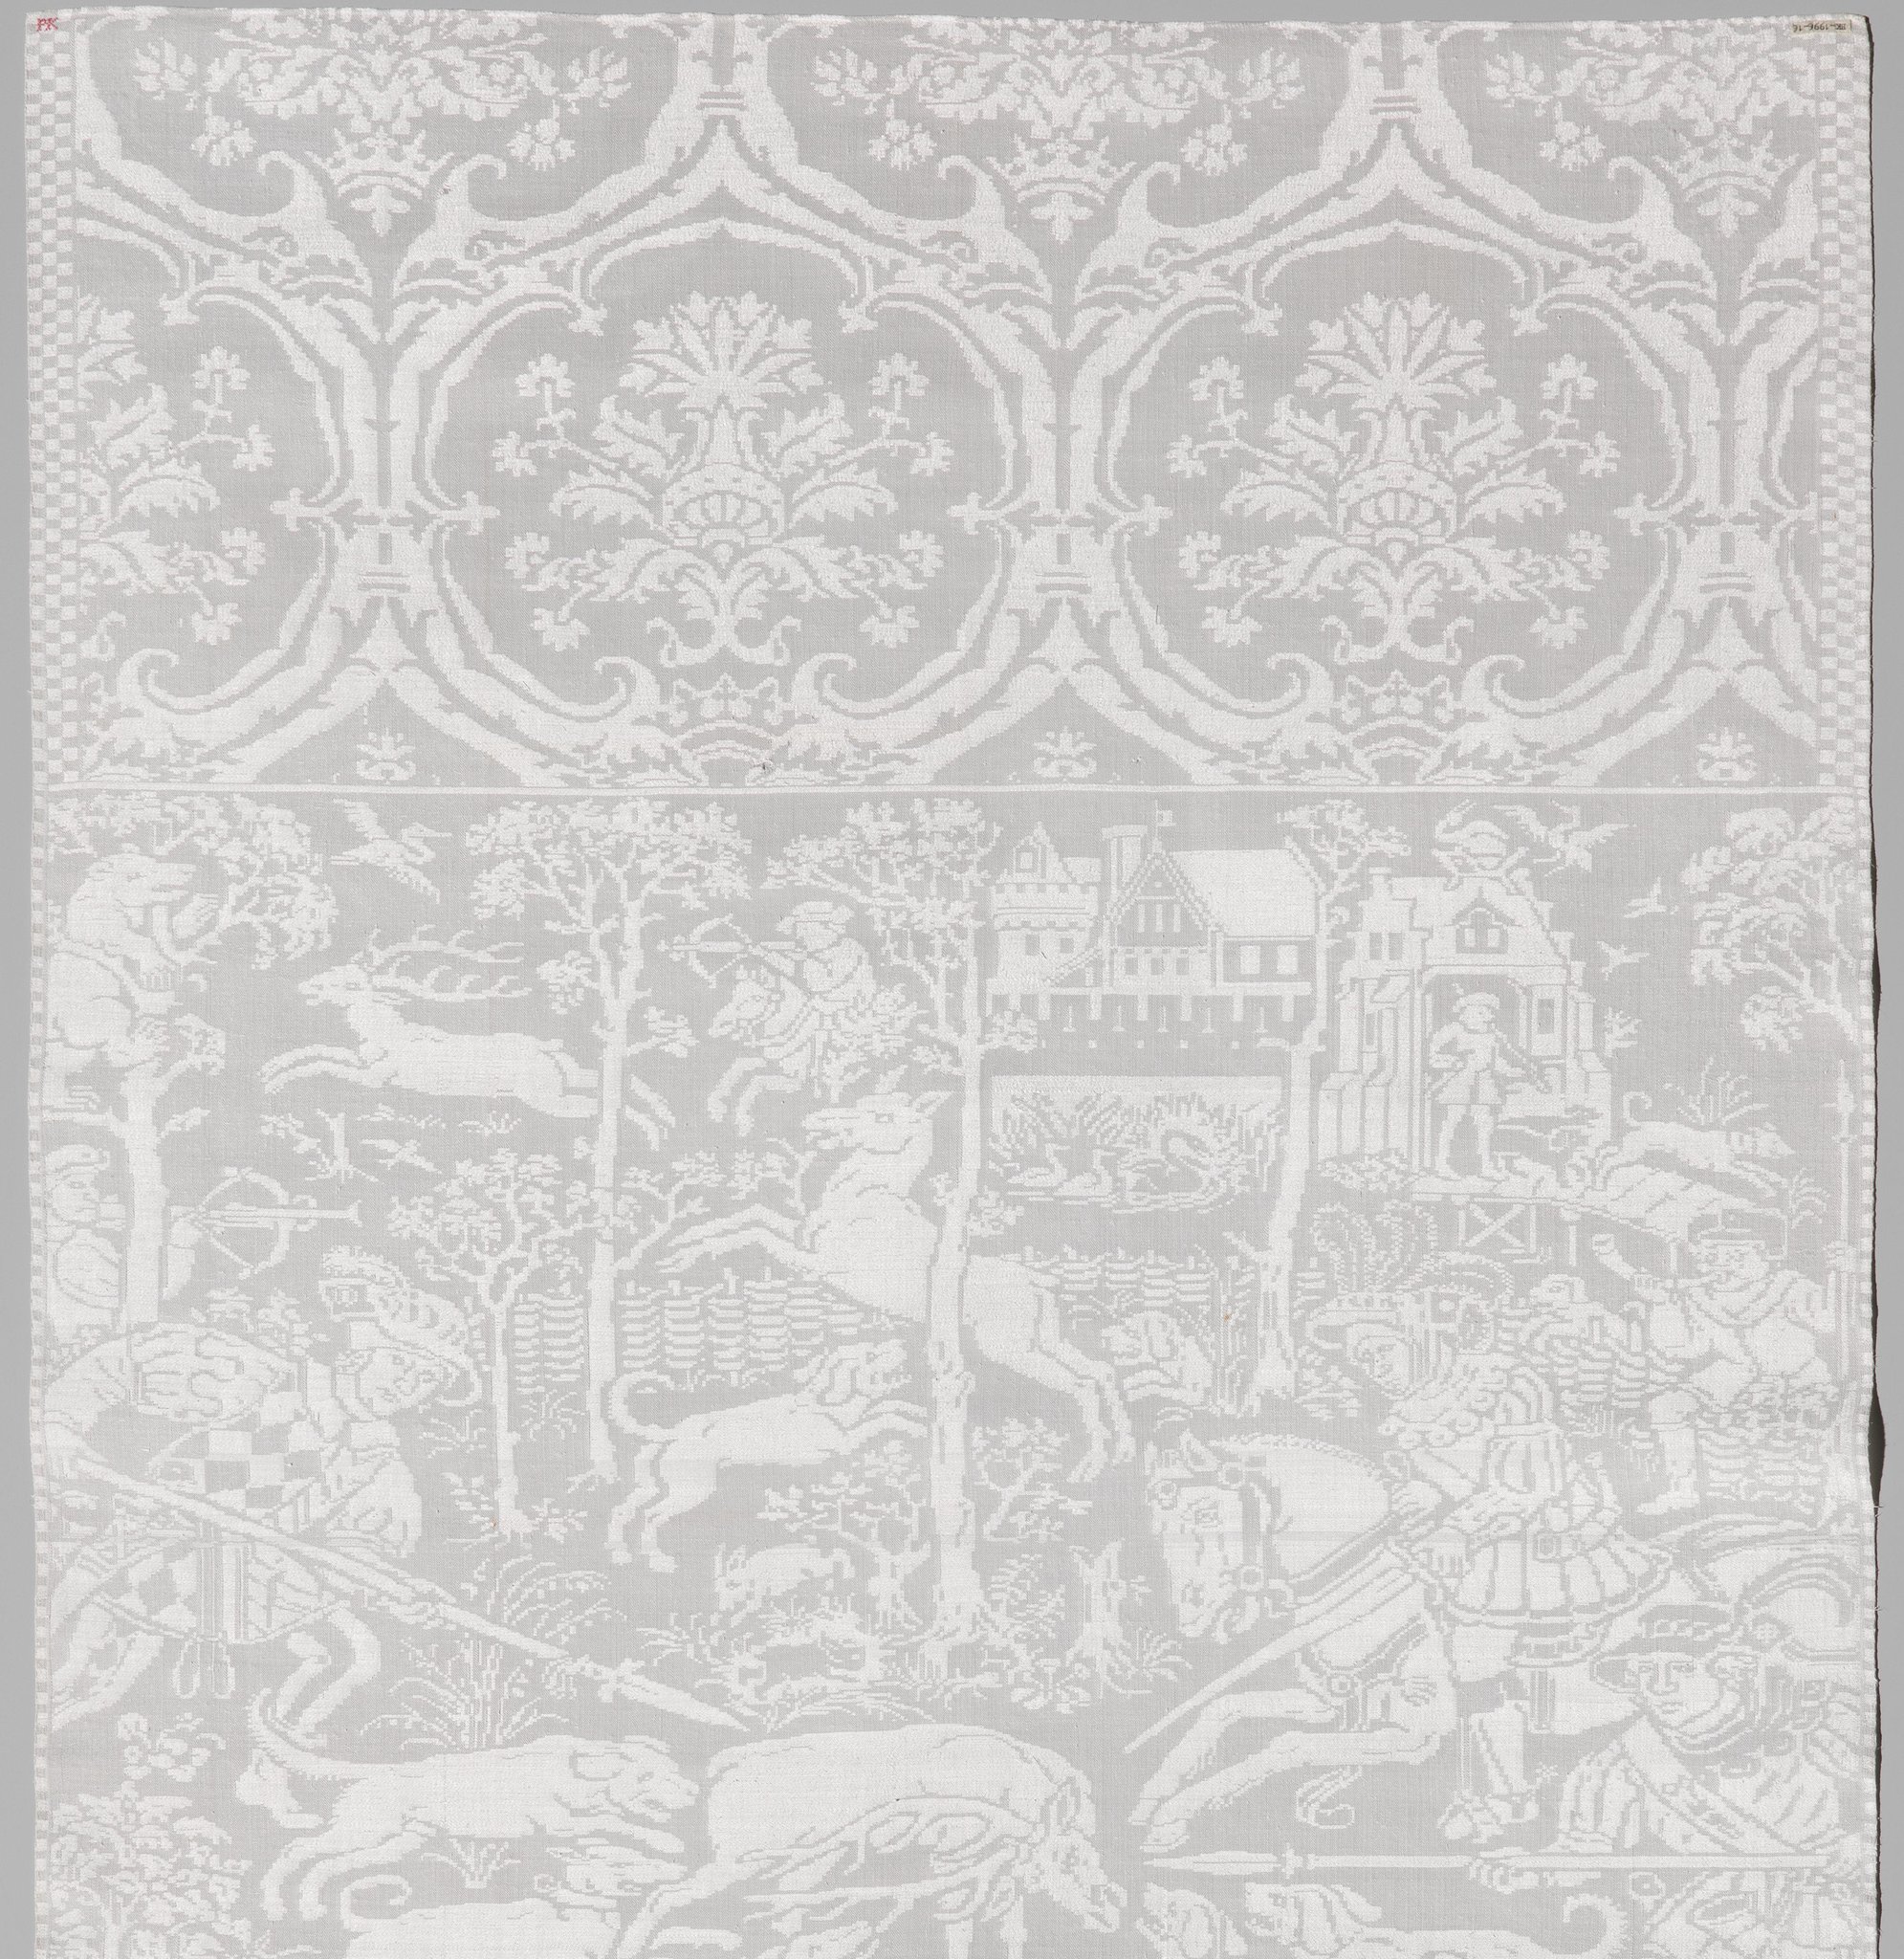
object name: napkin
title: Servet met een jachttafereel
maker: Anonymous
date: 1550-1599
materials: linen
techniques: damask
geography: flanders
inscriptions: mark: ‘20’, mark: ‘PK’